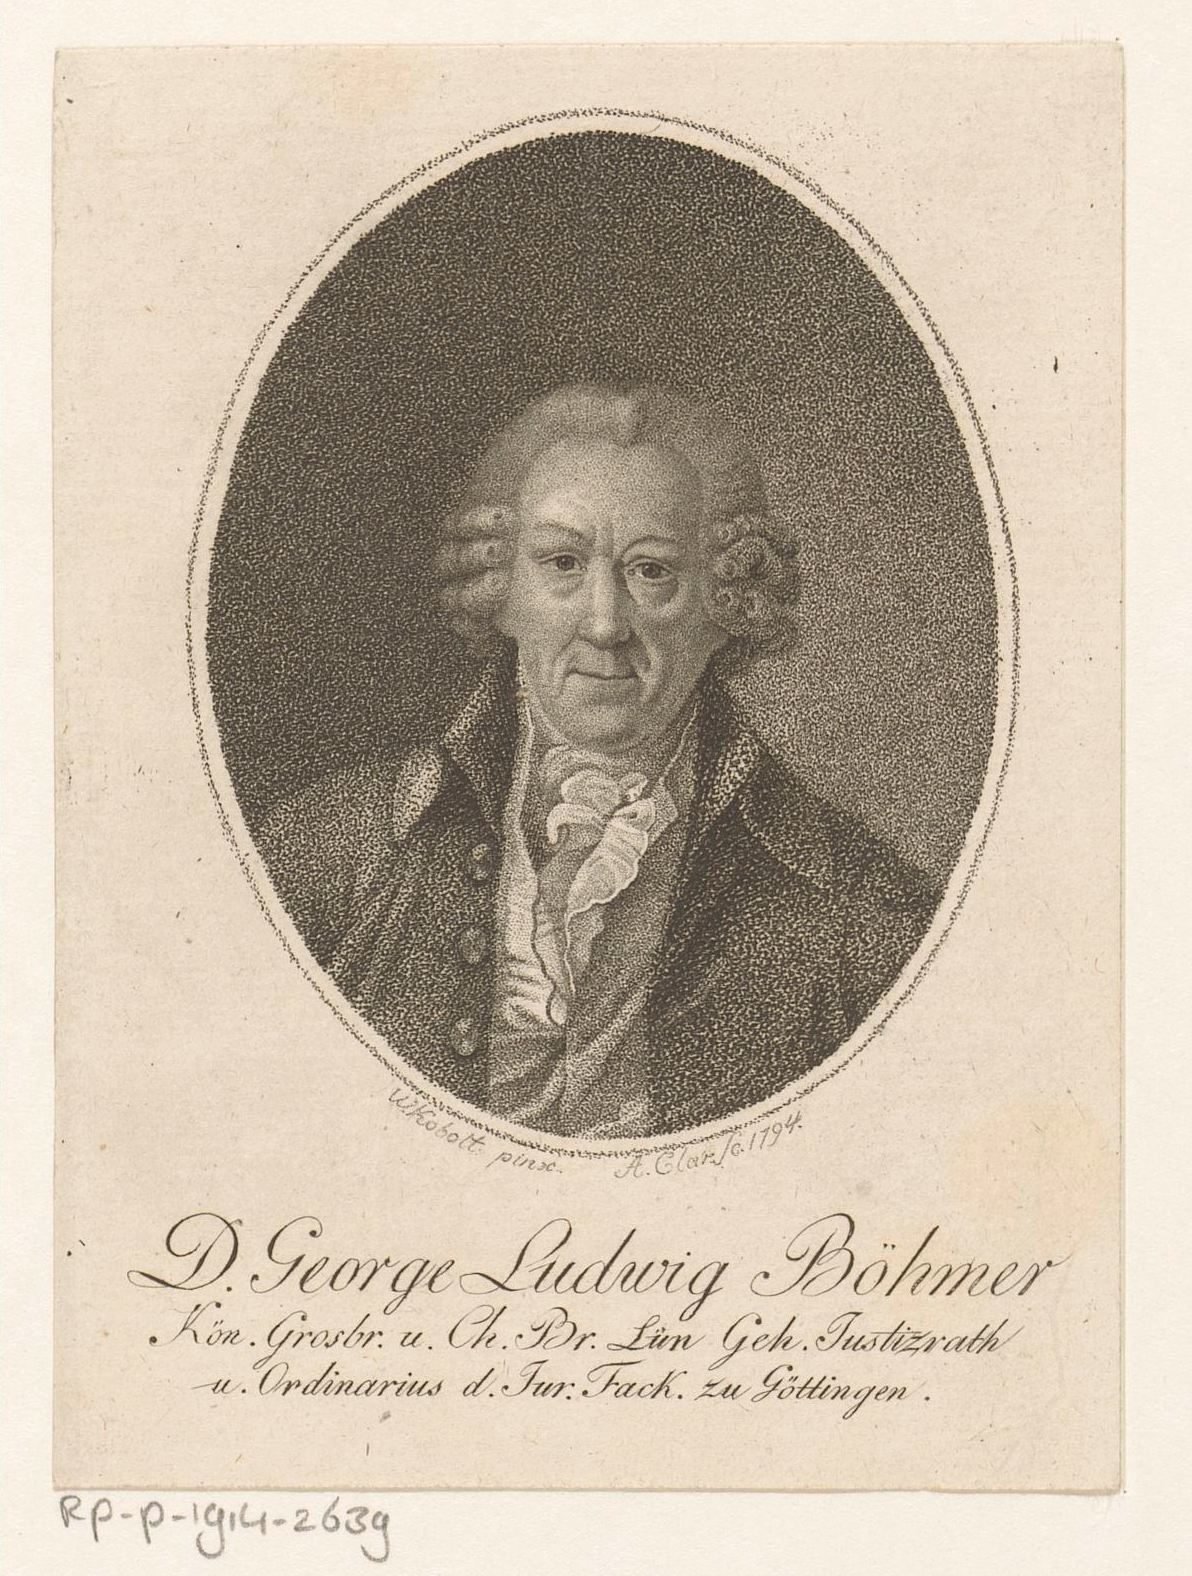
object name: print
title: Portret van Georg Ludwig Böhmer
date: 1794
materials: paper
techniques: stippling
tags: historical persons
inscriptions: collector's mark: Lugt 2228